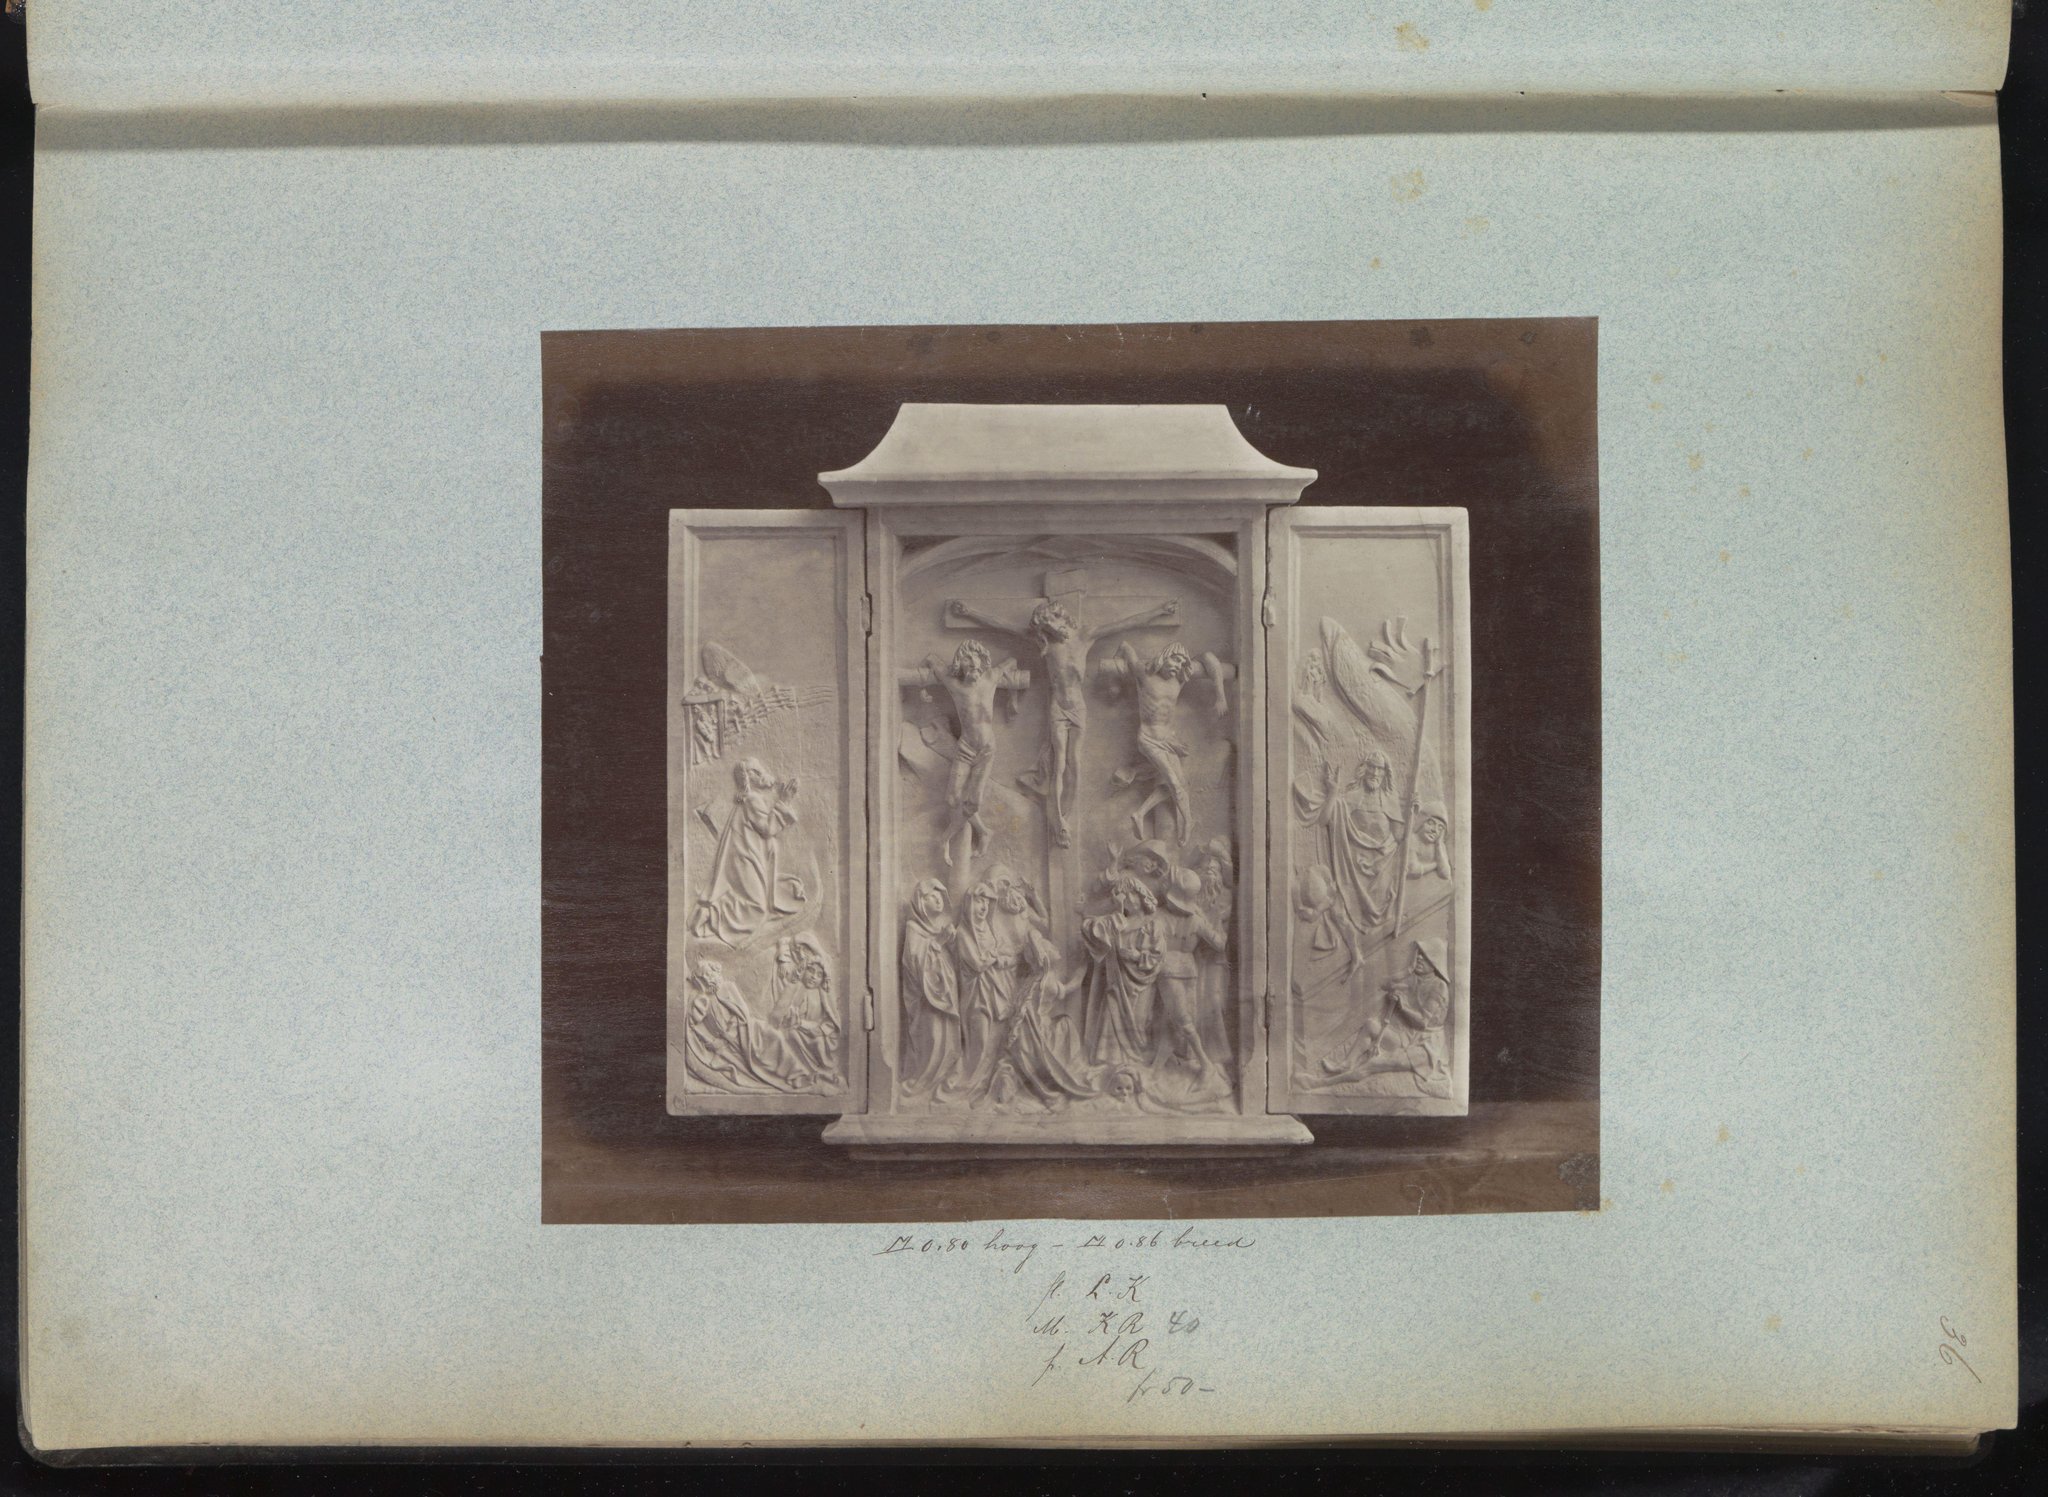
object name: album leaf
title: Gipsen afgietsel van een drieluik sculptuur met kruisigingsscène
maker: Anonymous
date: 1875-1900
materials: paper, photographic support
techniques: albumen print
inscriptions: annotation: ‘M 0.80 hoog M 0.86 breed’, annotation